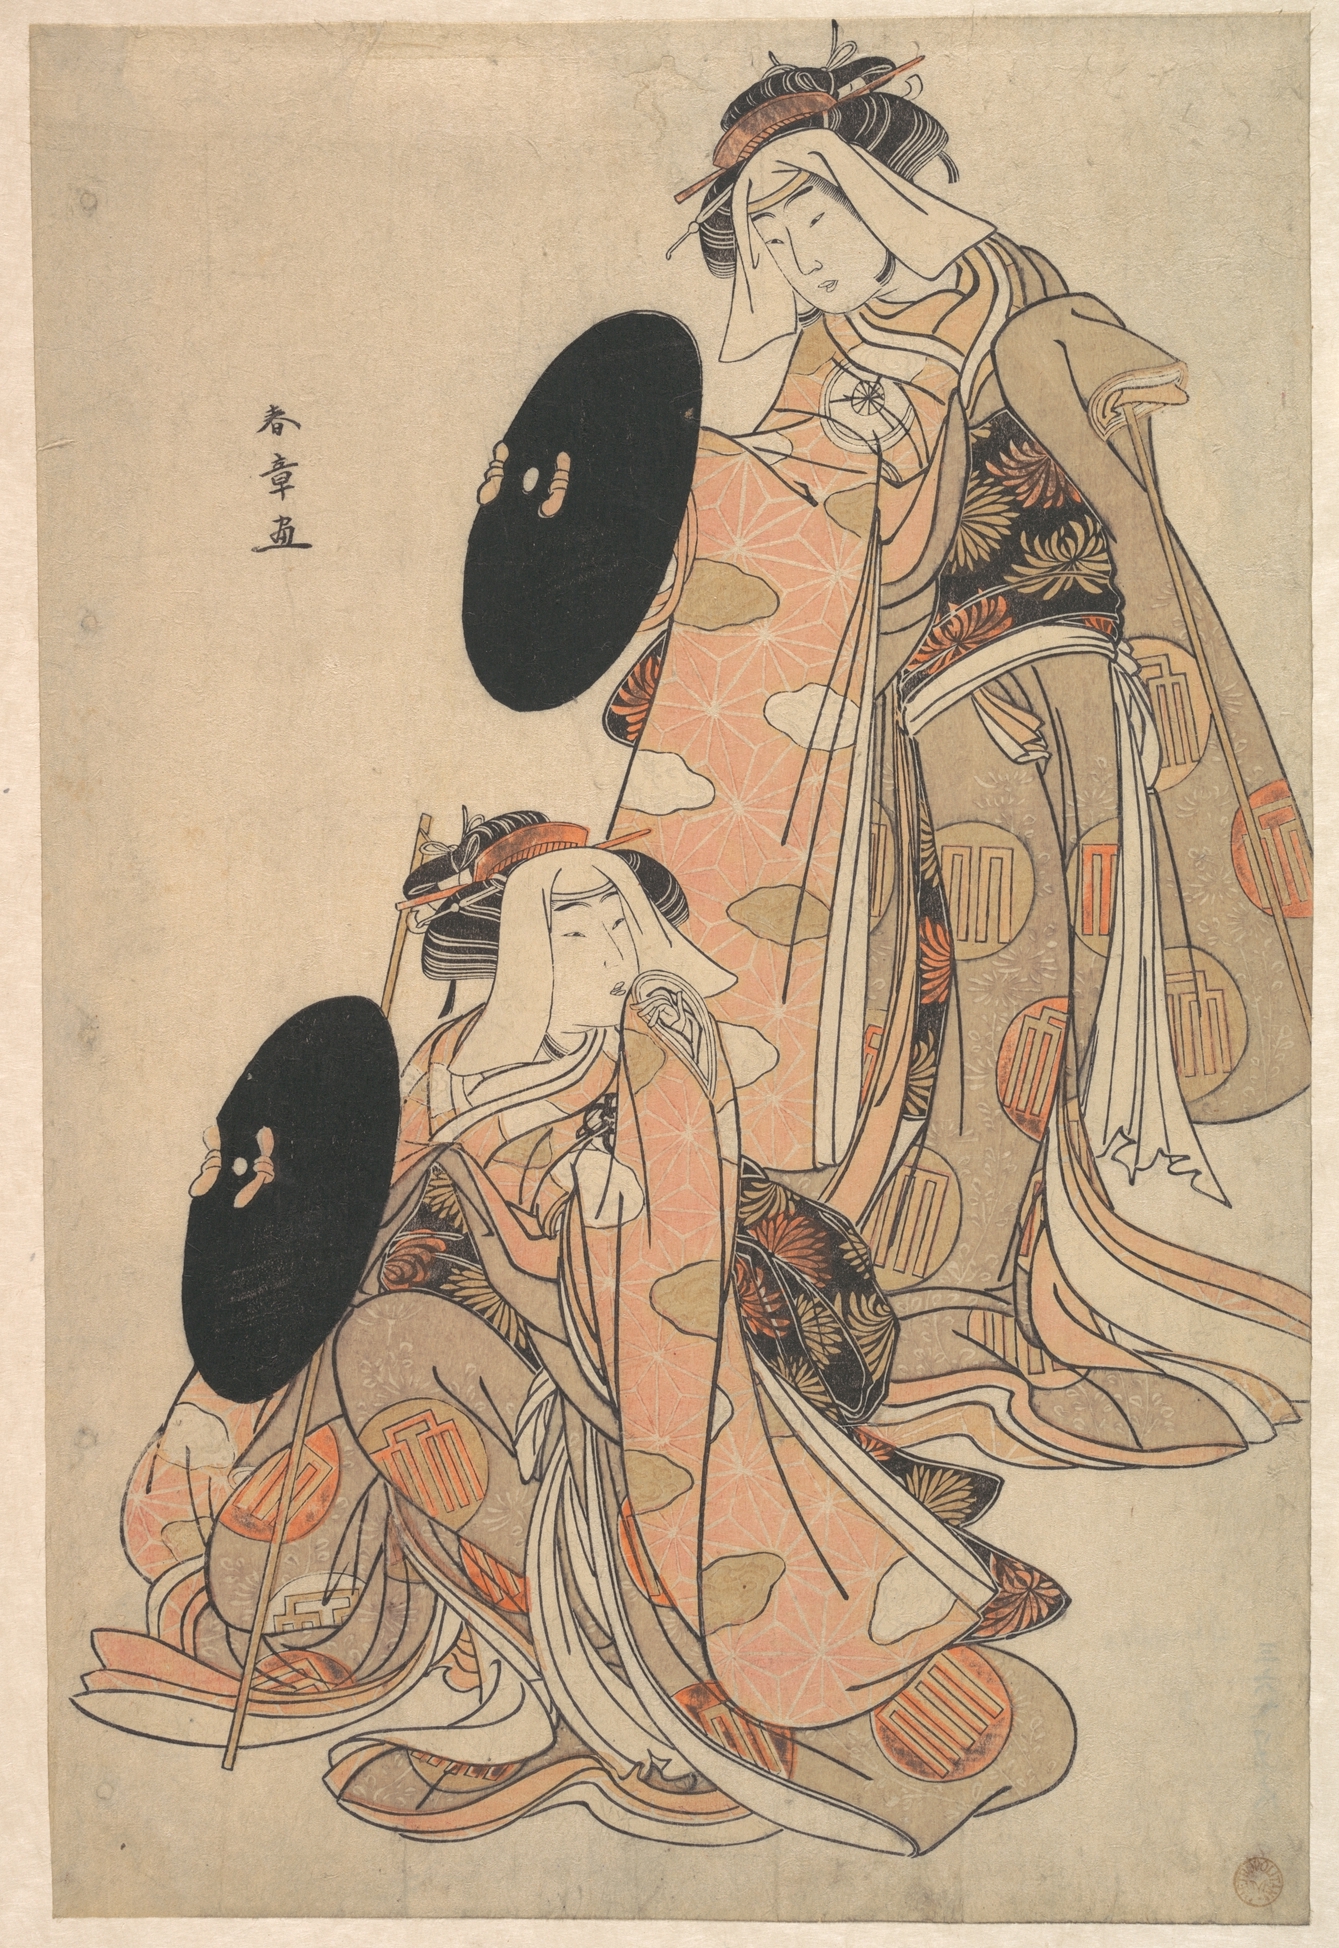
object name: woodblock print nishiki e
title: The Actors IV Iwai Hanshiro and I Bando Mitsugoro as Women Pilgrime in a shosa (Acting and Dancing) Performance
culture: japanese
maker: katsukawa shunshō 勝川春章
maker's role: artist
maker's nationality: japanese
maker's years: 1726-1792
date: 1776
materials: ink, paper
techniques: nishiki e, woodblock print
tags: men,women,actors